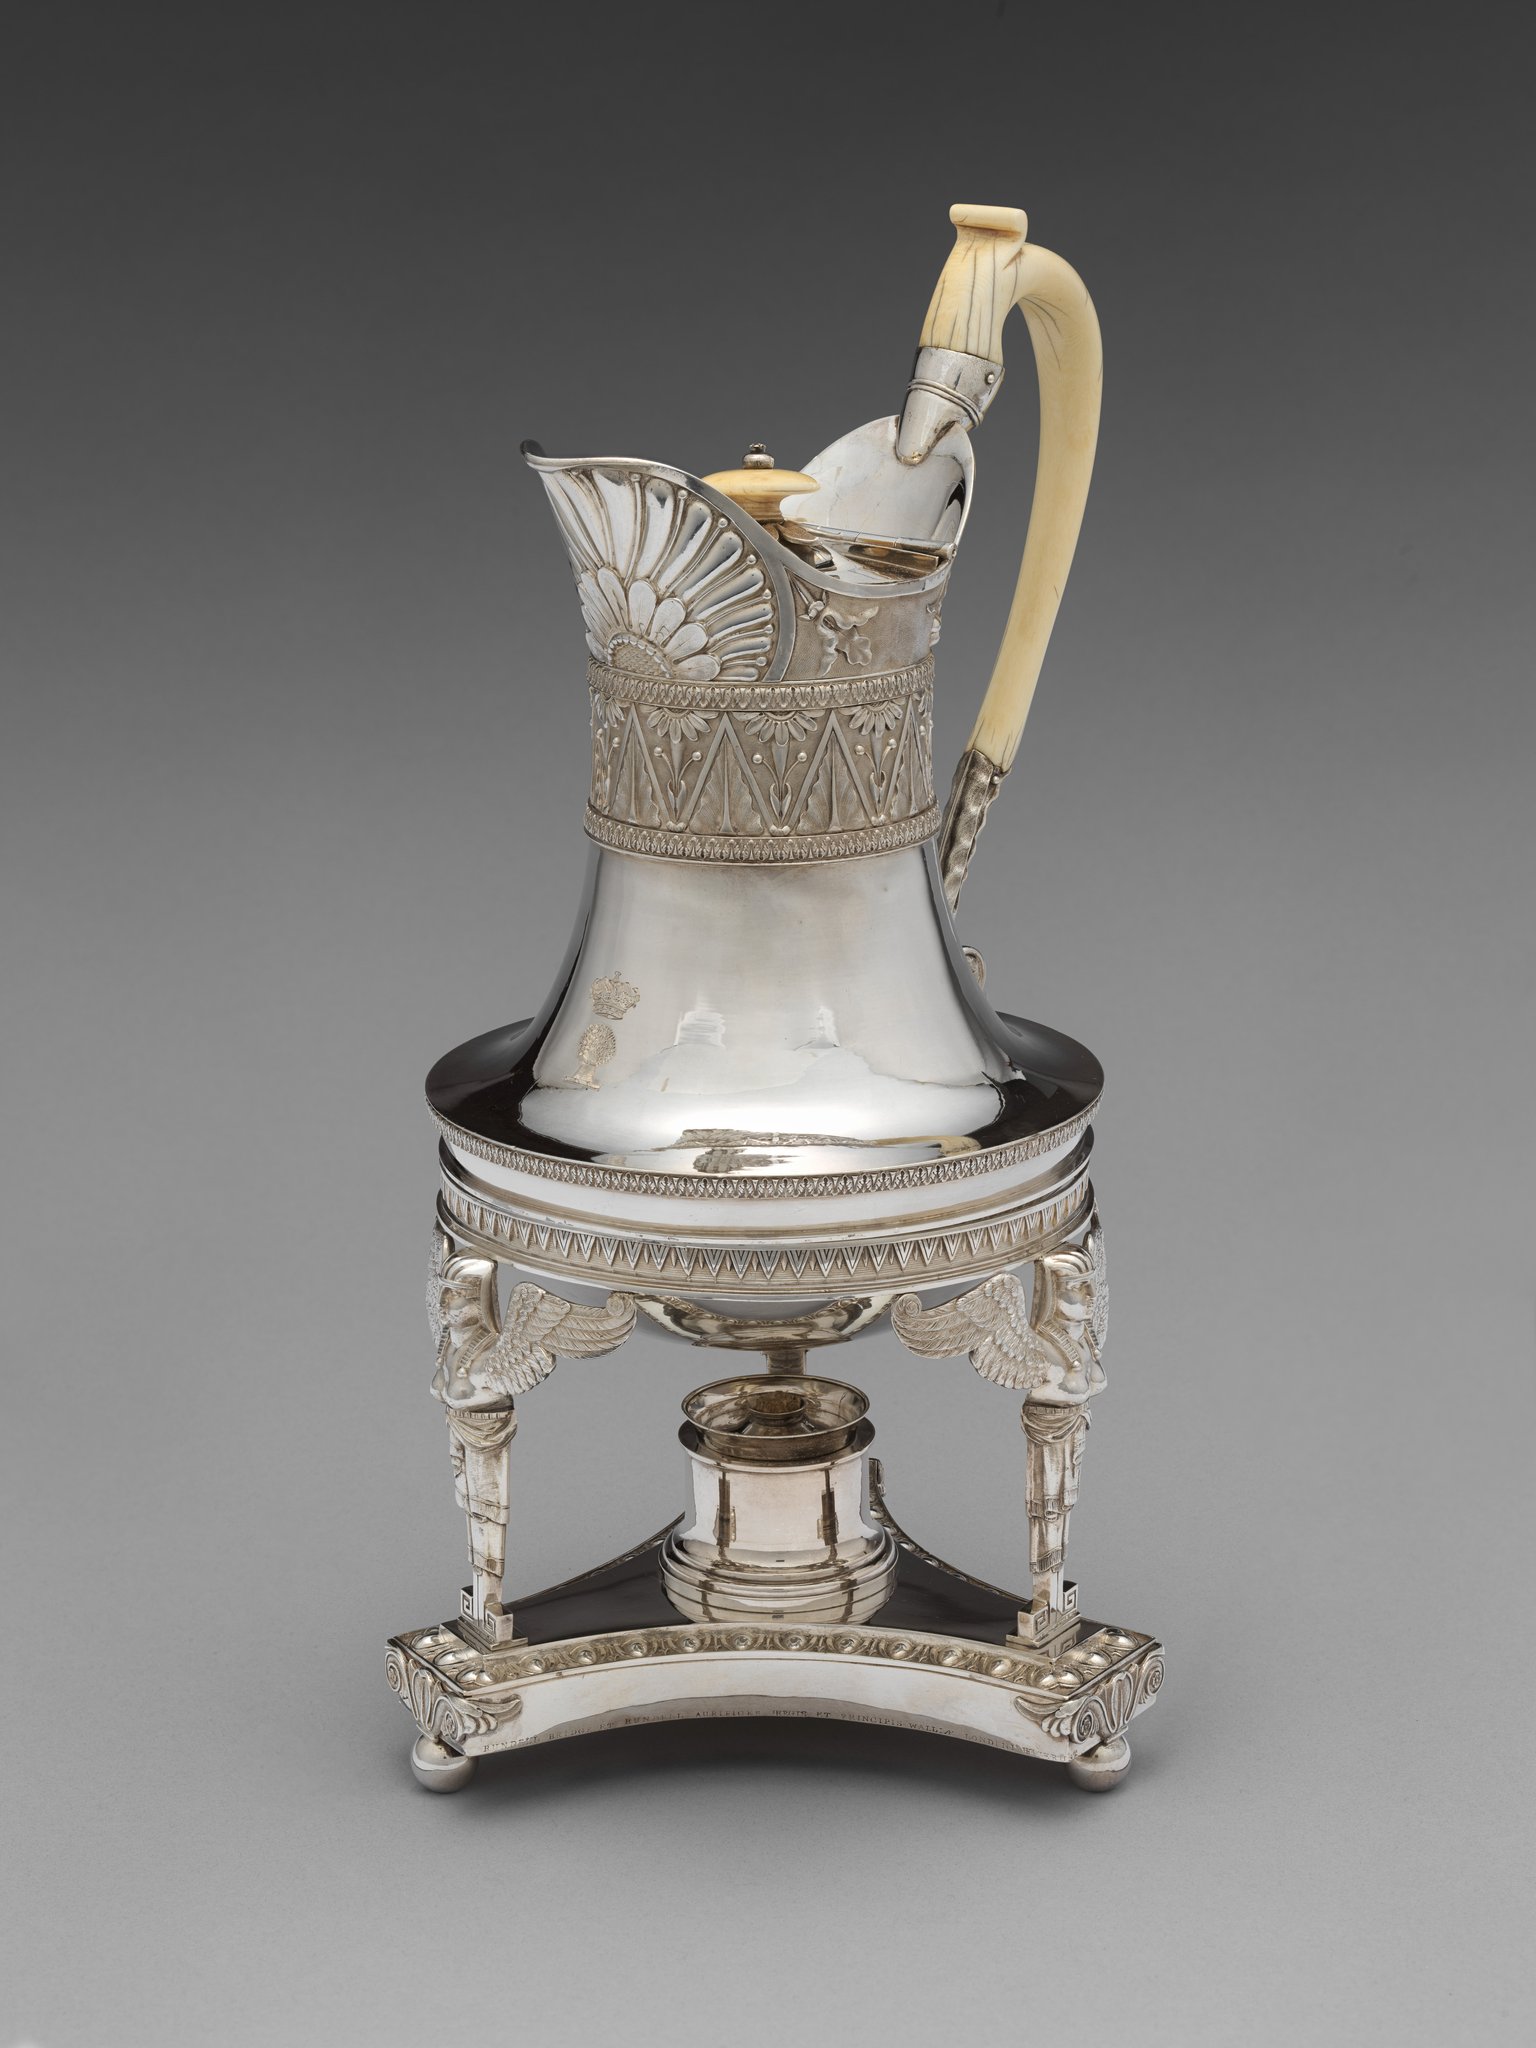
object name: coffee pot on stand part of a service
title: Coffee Pot on Stand (part of a service)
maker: digby scott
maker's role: maker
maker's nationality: british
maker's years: 1780-1880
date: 1805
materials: ivory, silver